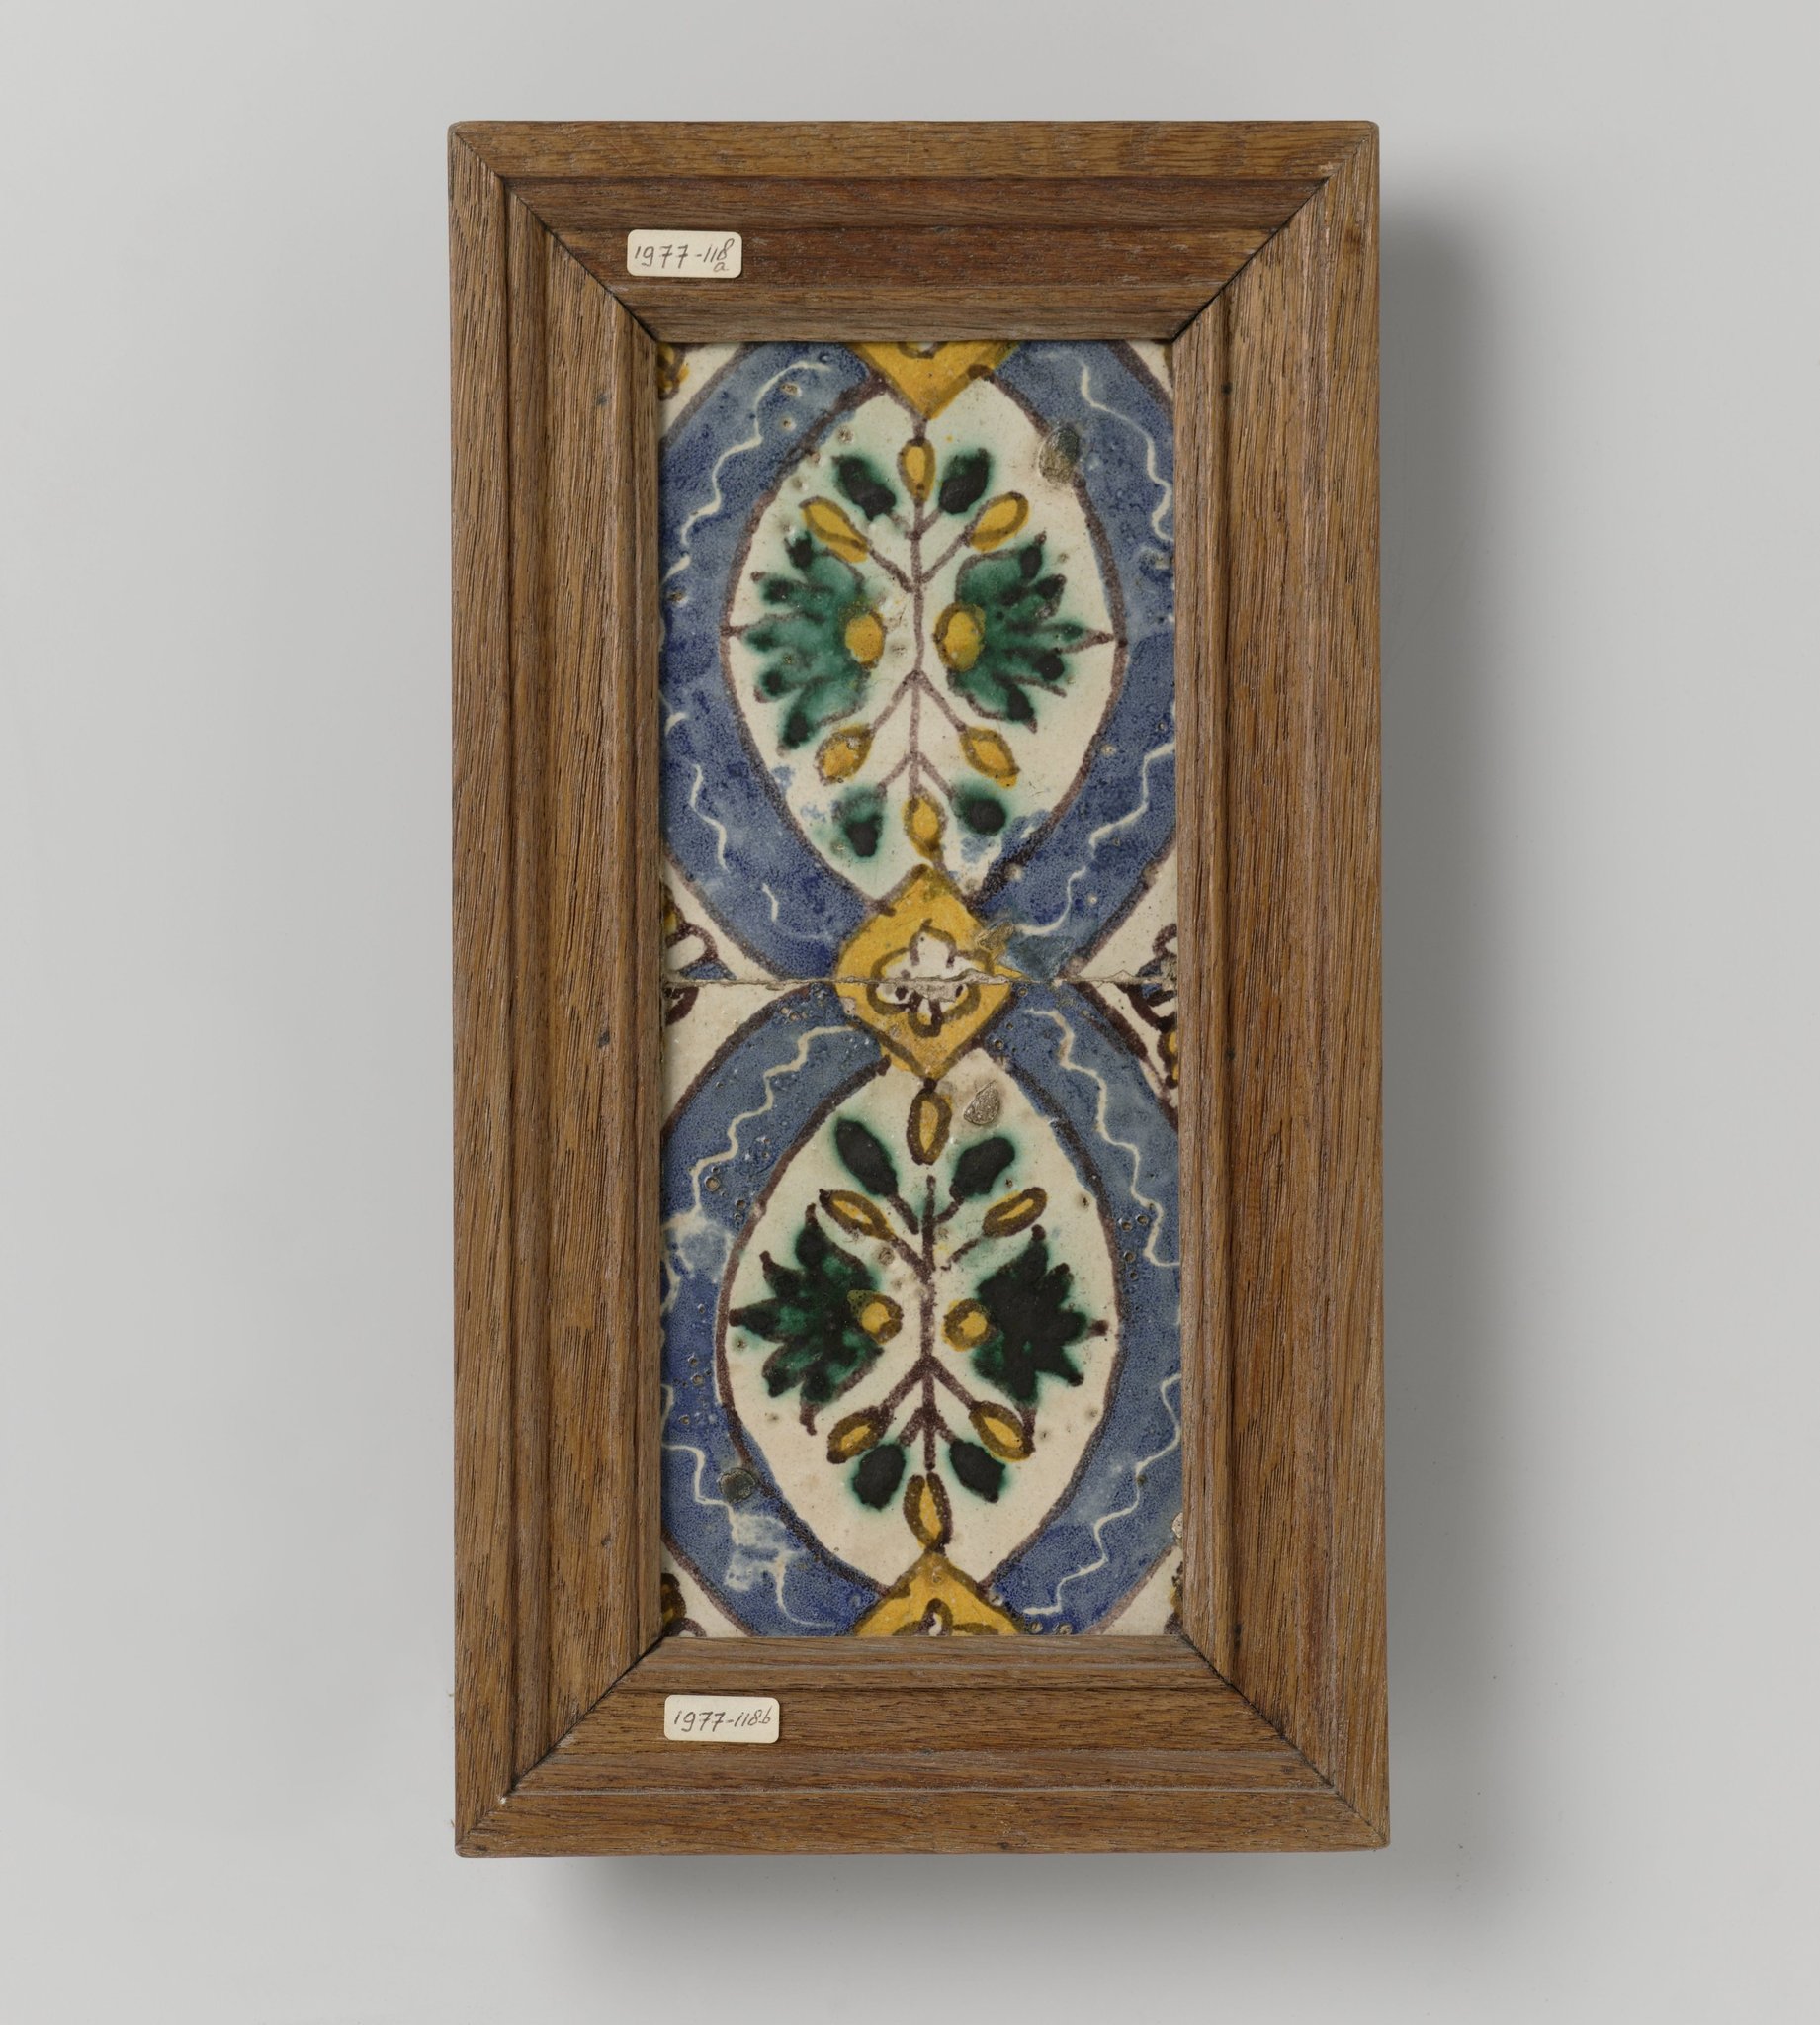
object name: tile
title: Tegel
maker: Anonymous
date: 1700-1800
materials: earthenware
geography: spain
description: Tegel van aardewerk, beschilderd in blauw, groen, geel en mangaan, blauw ovaal waarbinnen symmetrisch bladmotief. In de hoeken delen van rozetten. Met BK-1977-118-b in moderne houten lijst.